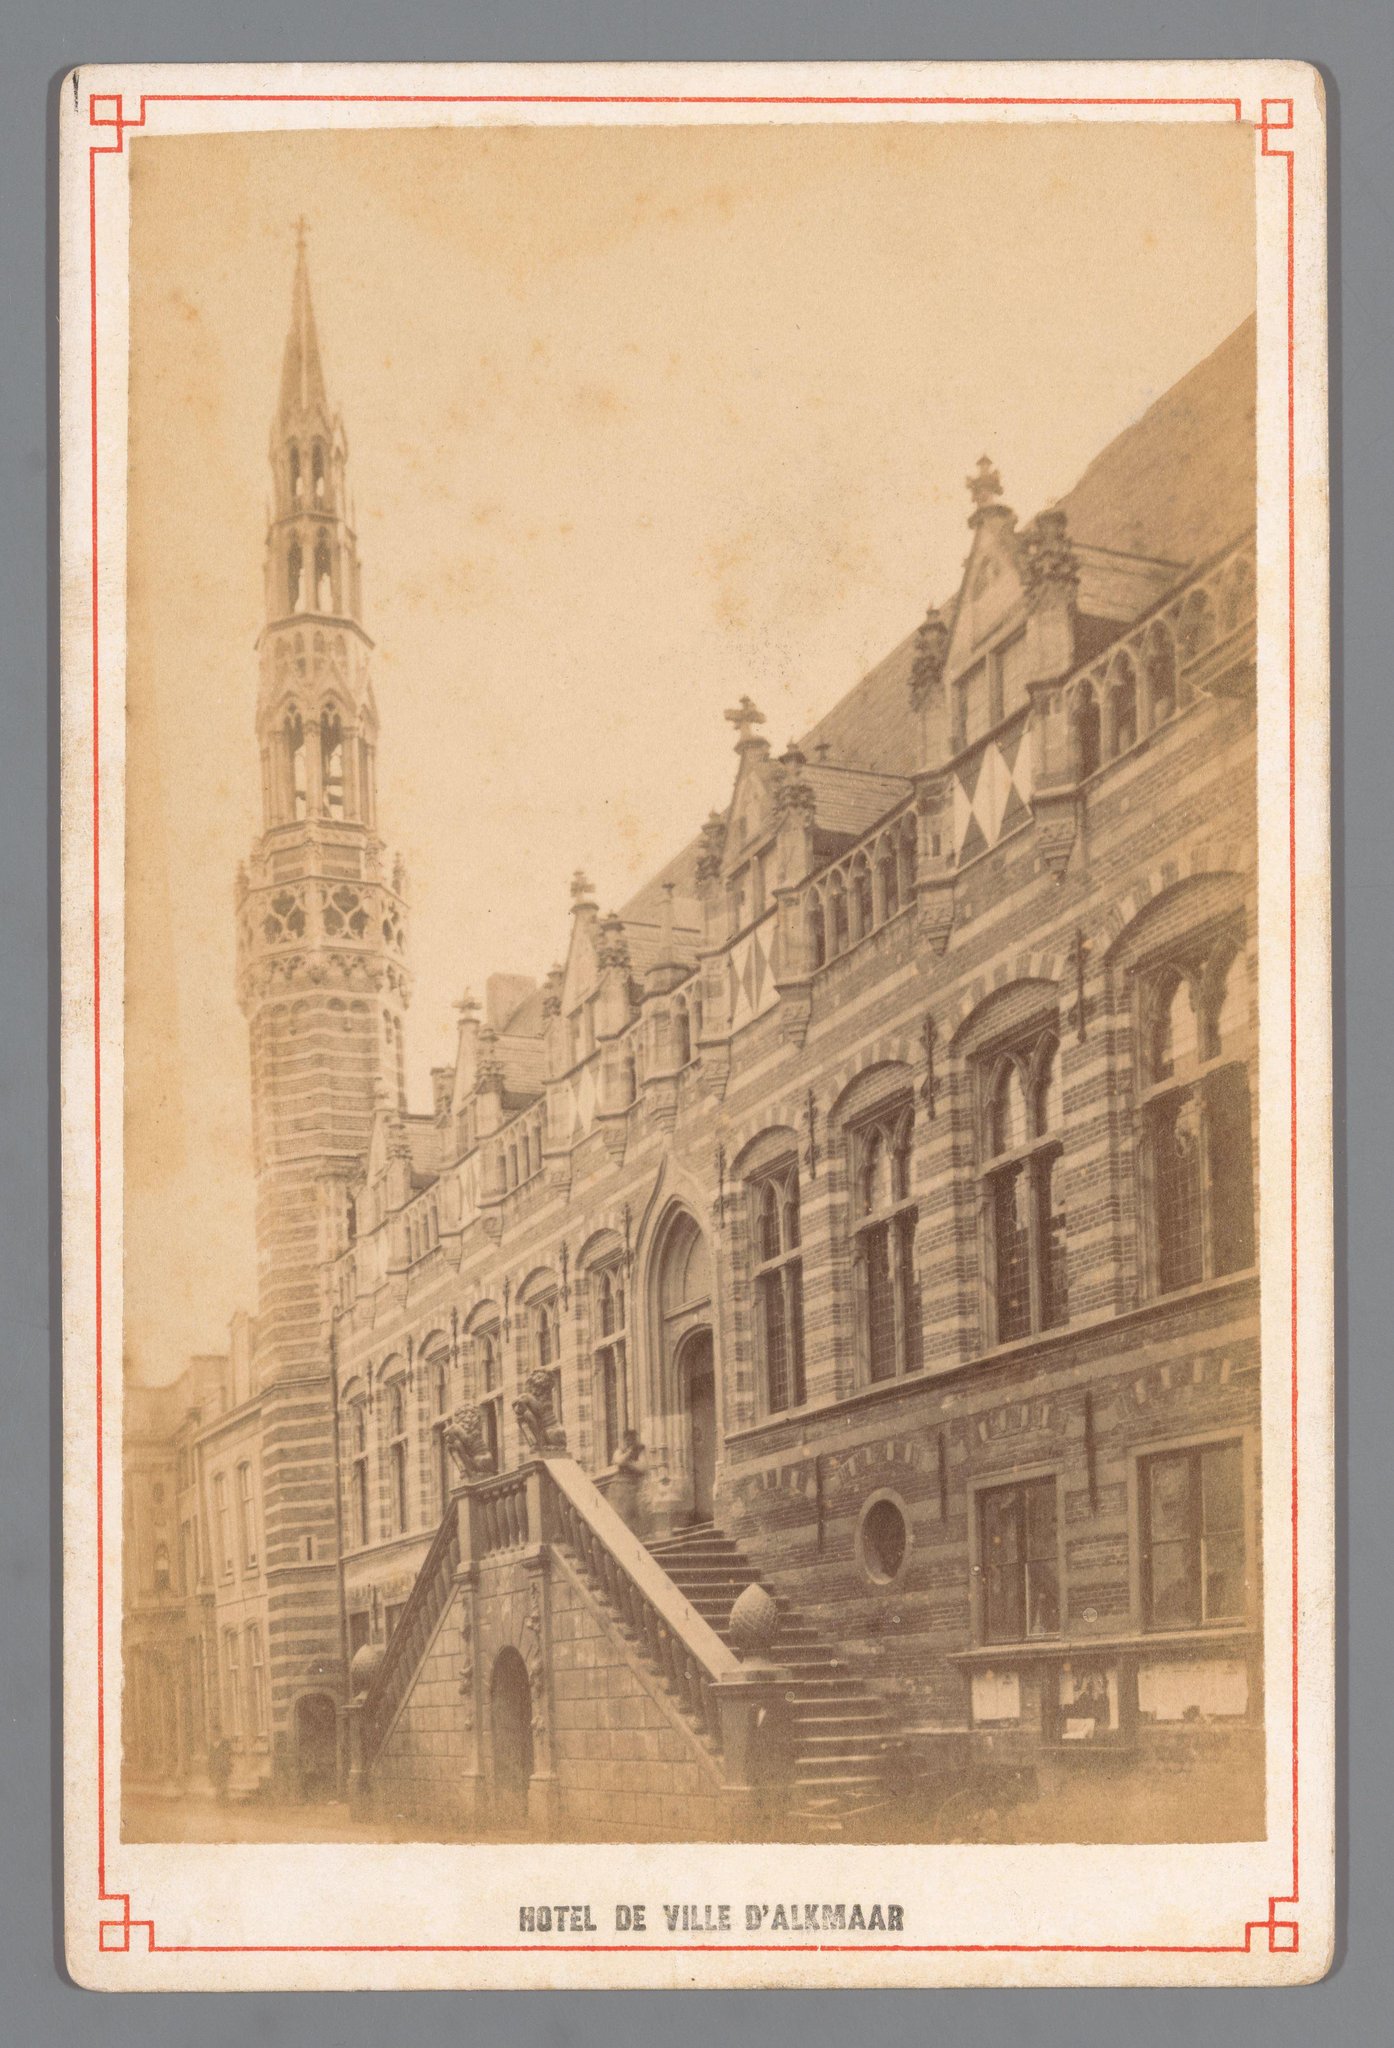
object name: photograph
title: Hotel de Ville d'Alkmaar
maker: Anonymous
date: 1865-1880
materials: cardboard, photographic support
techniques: albumen print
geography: alkmaar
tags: townhall, façade (of house or building)